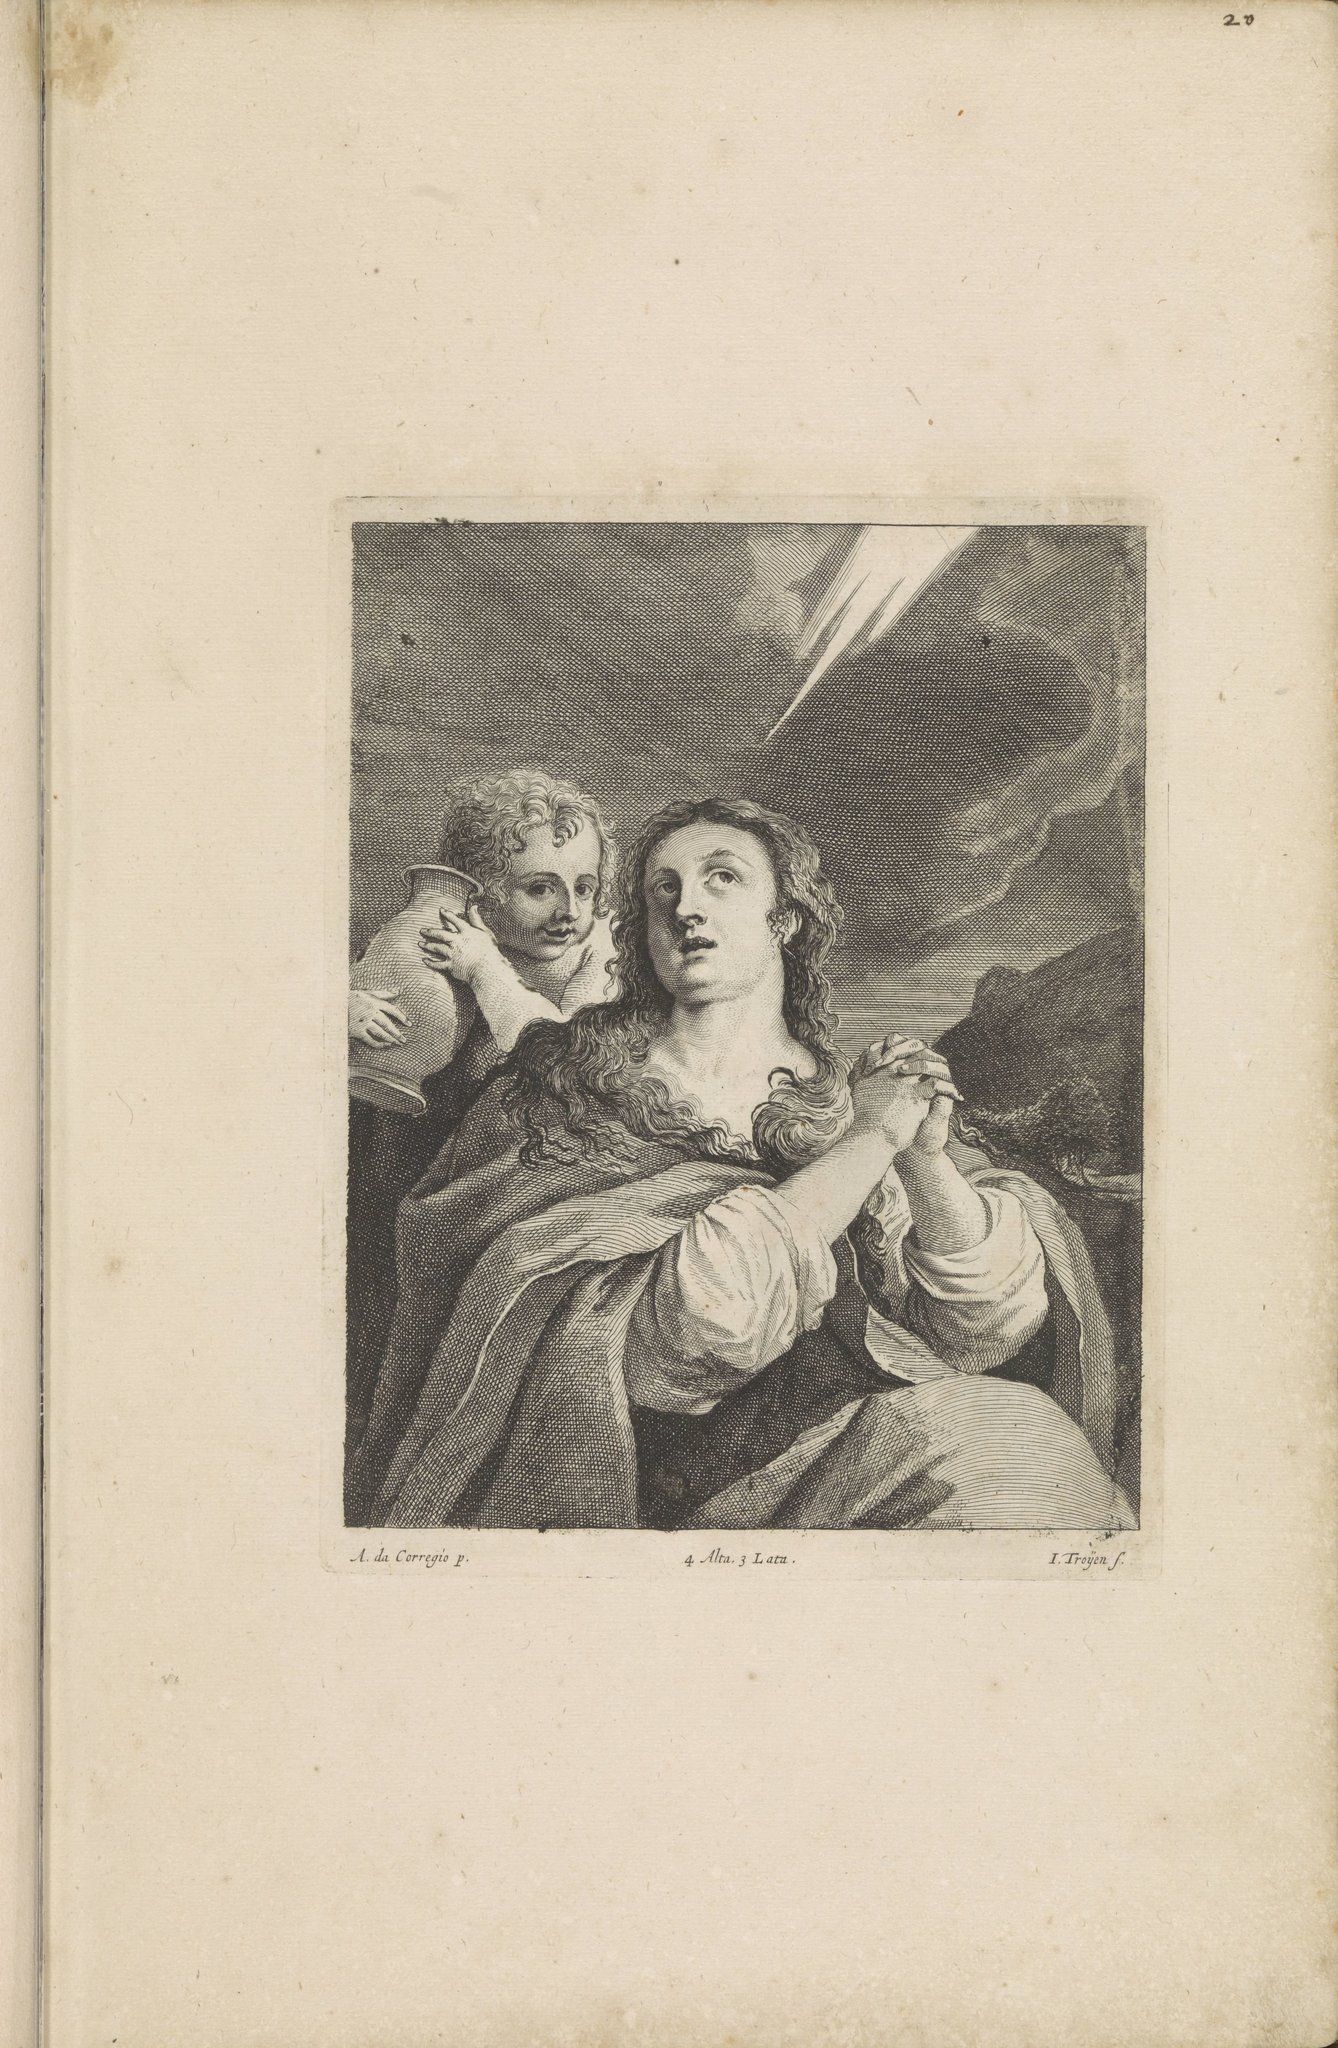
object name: album leaf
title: Boetvaardige Maria Magdalena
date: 1660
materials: paper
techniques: engraving, etching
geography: brussels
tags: the penitent st. mary magdalene (often before a cave, possibly at la sainte-baume hill): her long hair covers her (naked) body, she reads, meditates or raises her tear-filled eyes towards heaven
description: Prent naar het schilderij van Schedoni dat zich in de collectie van het Kunsthistorisches Museum te Wenen bevindt (inventarisnummer: GG_1615). David Teniers heeft waarschijnlijk van alle schilderijen uit de collectie van Leopold Willem van Oostenrijk een olieverfstudie op doek of paneel vervaardigd (zgn. pasticcio), die als voorbeeld voor de prentmakers diende. Het is niet altijd duidelijk of de pasticci door hem zijn gemaakt of door zijn atelier. Niet alle pasticci zijn overgeleverd.